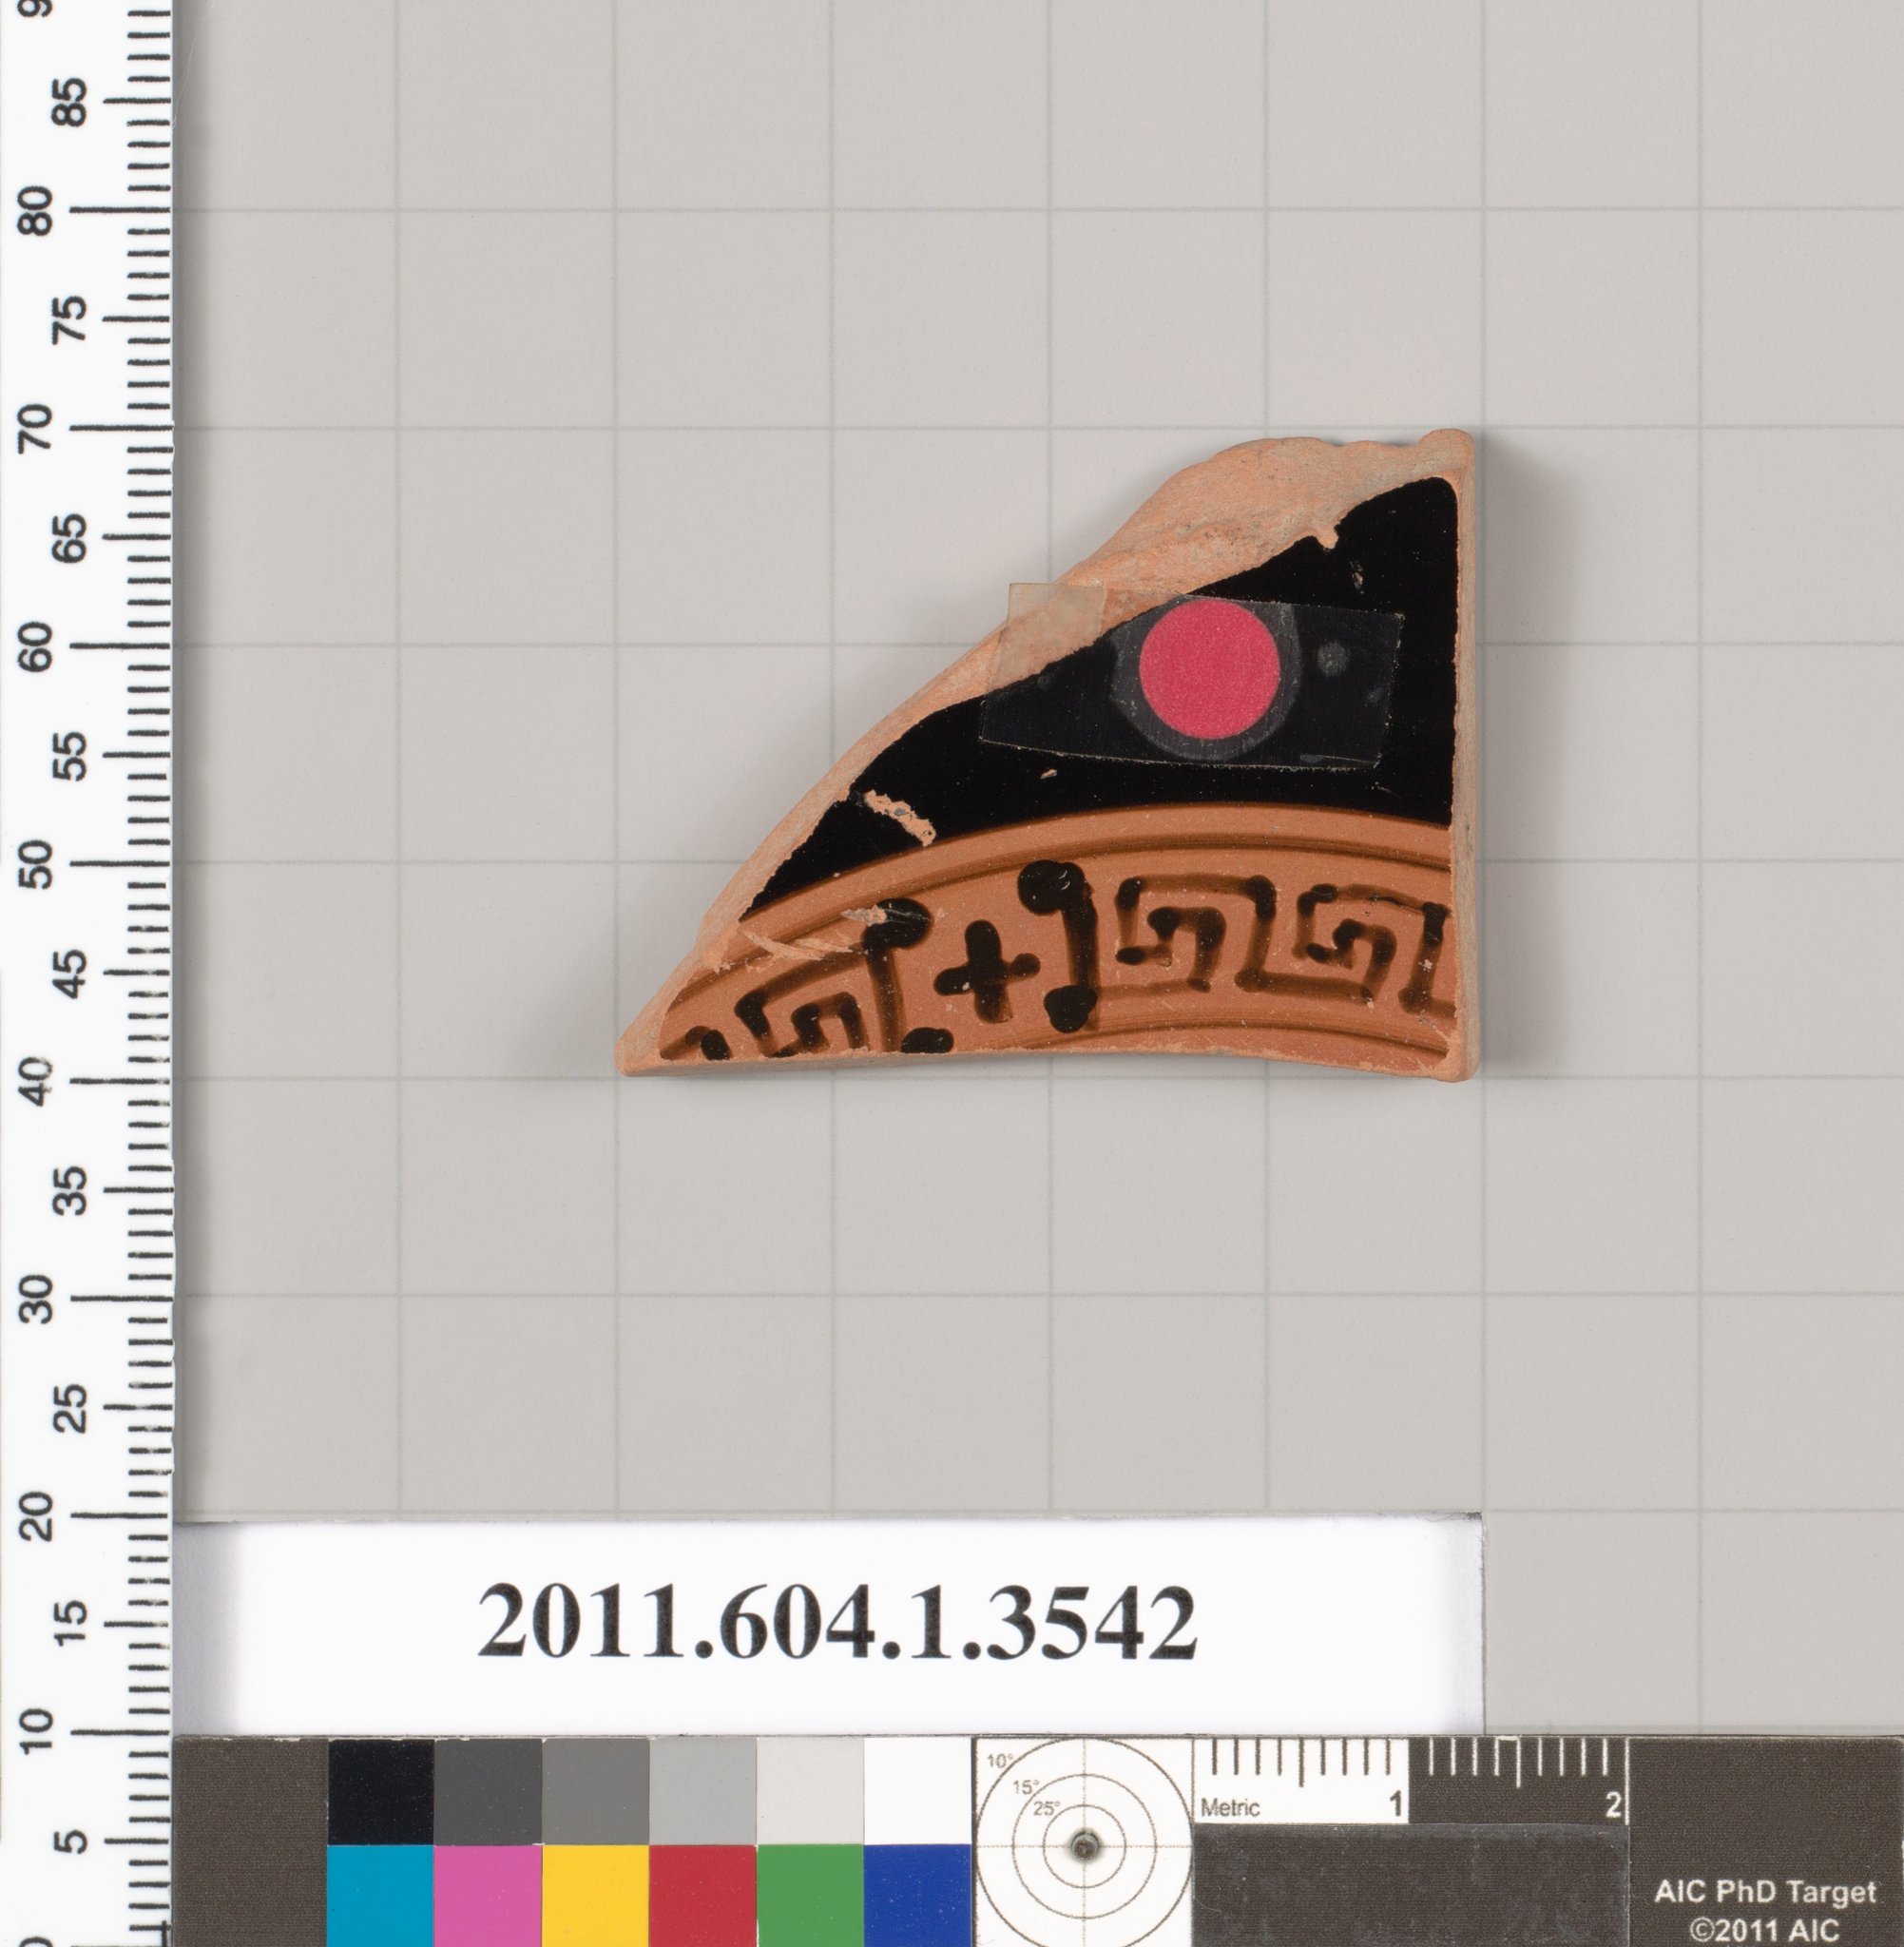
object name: kylix fragment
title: Terracotta fragment of a kylix (drinking cup)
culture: greek, attic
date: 490-470 BCE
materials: terracotta